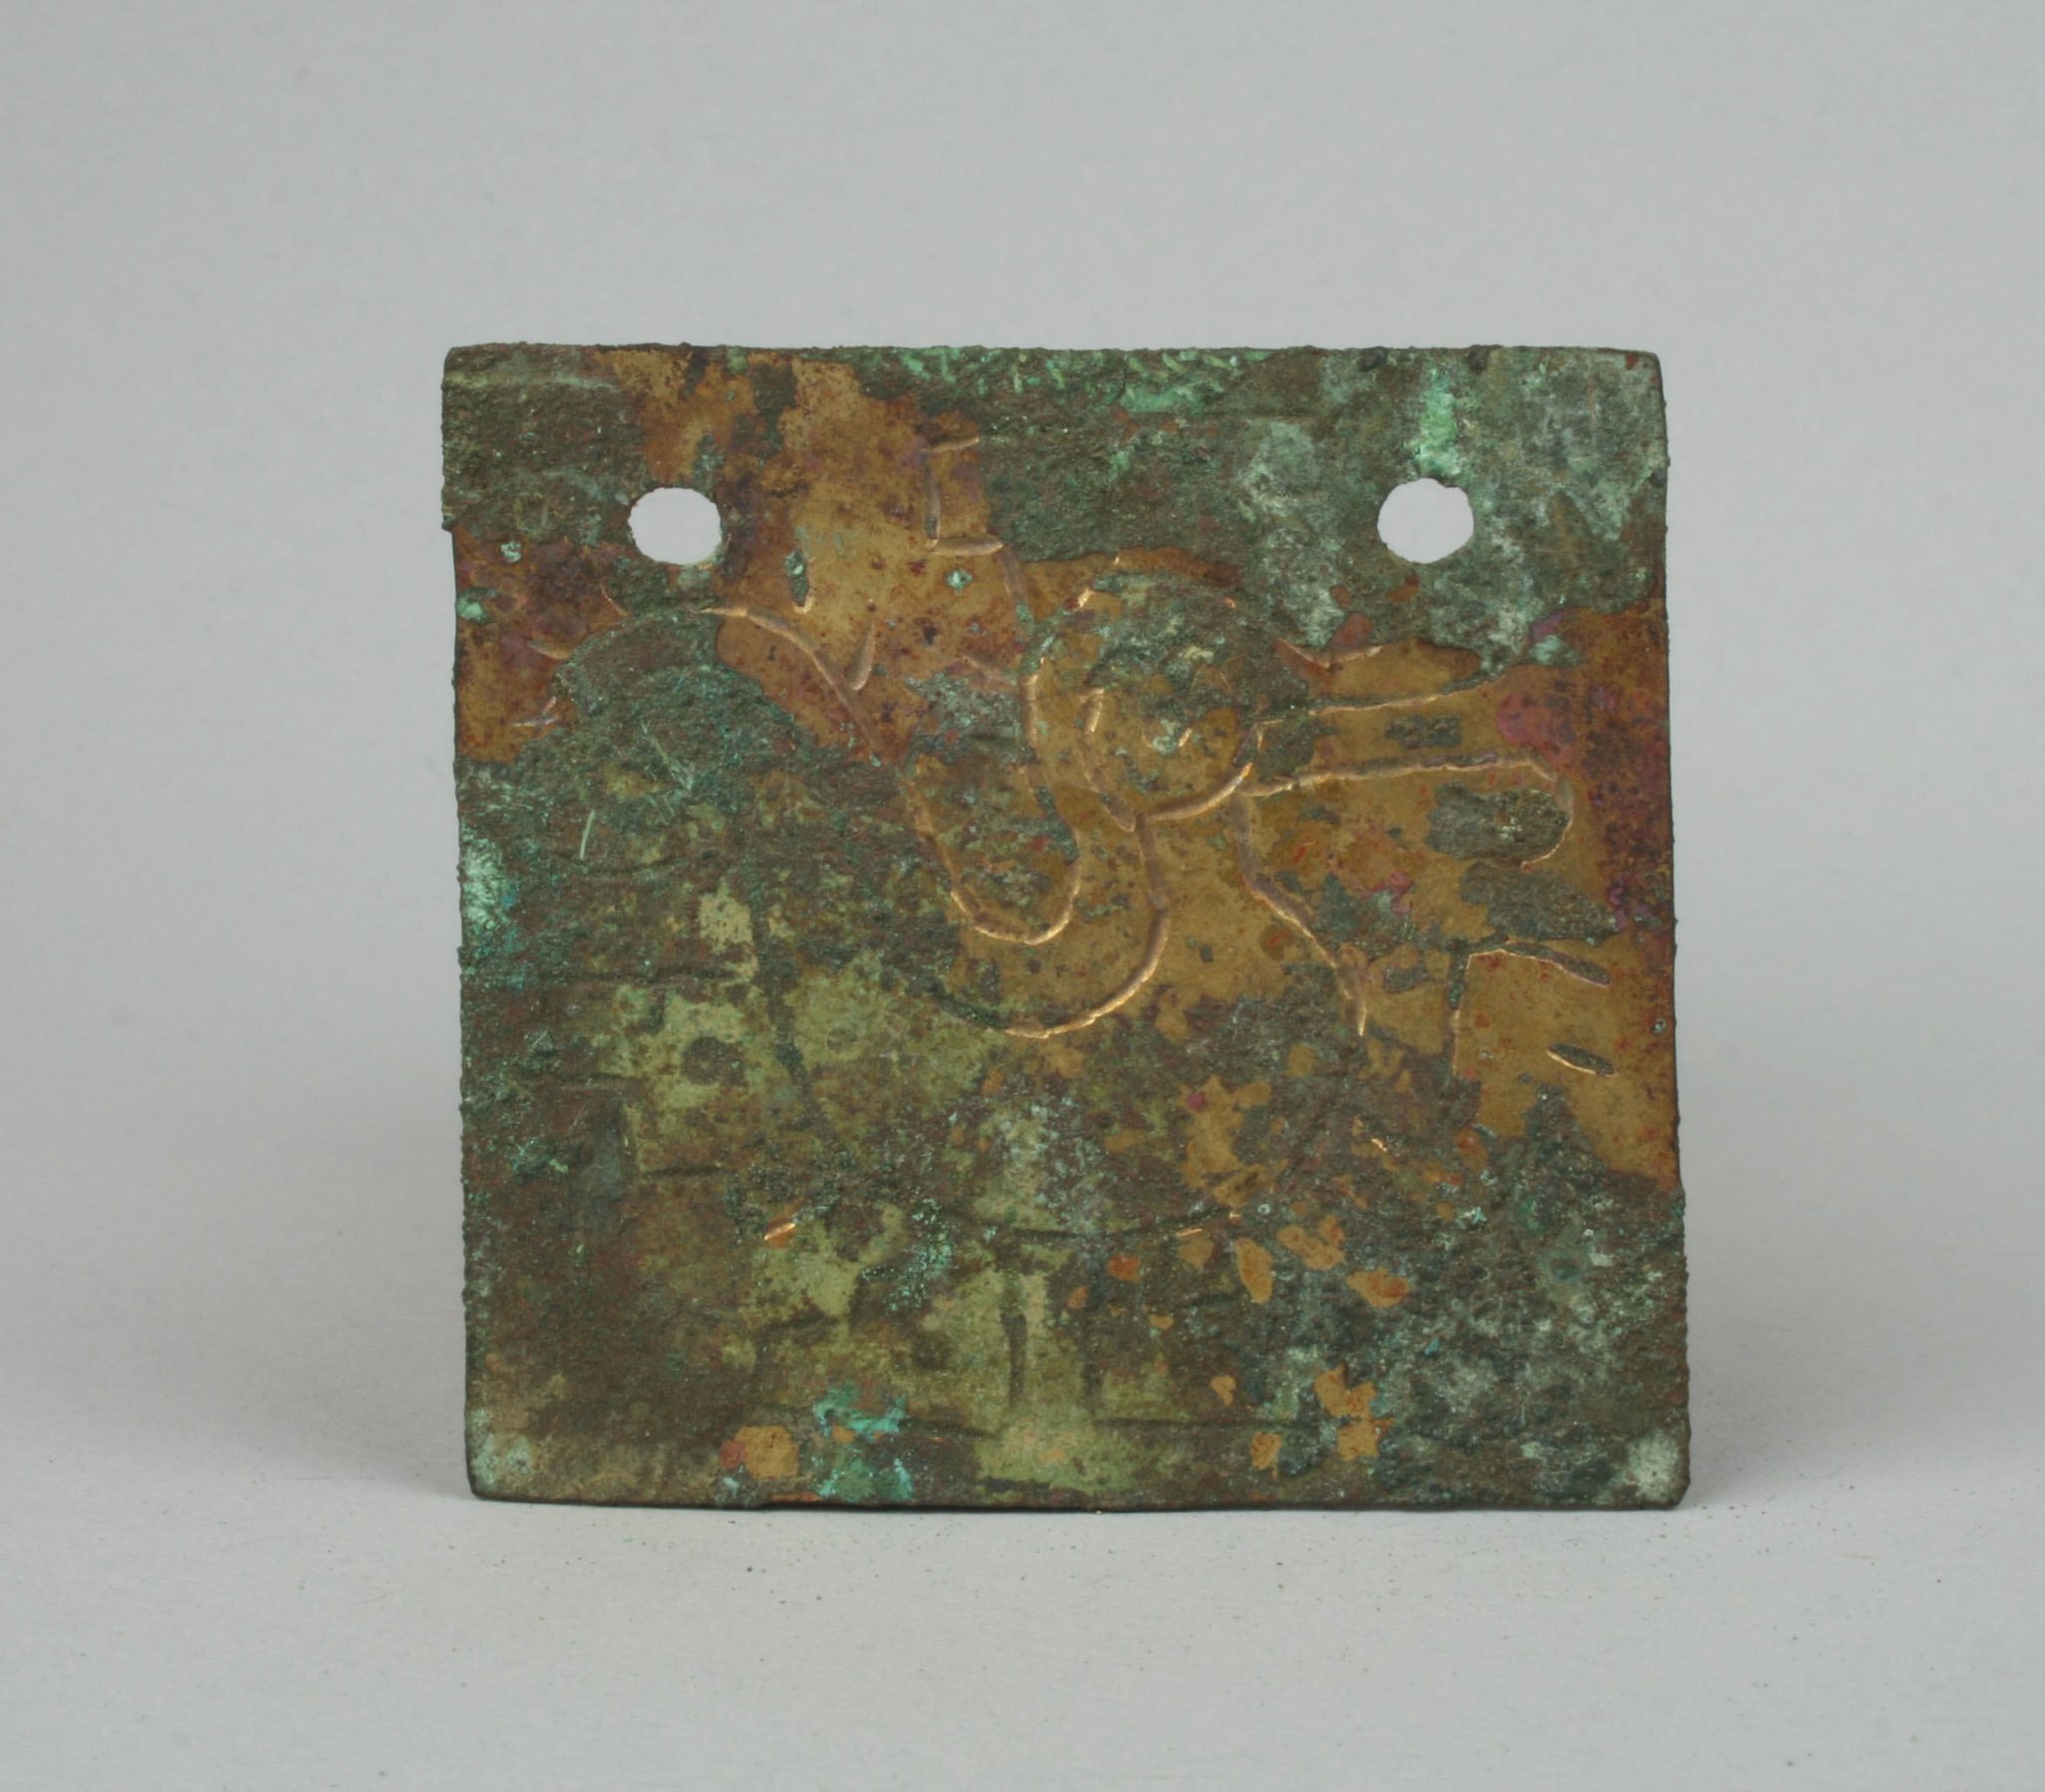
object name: ornament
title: Bird Plaque Ornament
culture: vicús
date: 300 BCE-200 CE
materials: copper, gilt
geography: peru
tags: birds